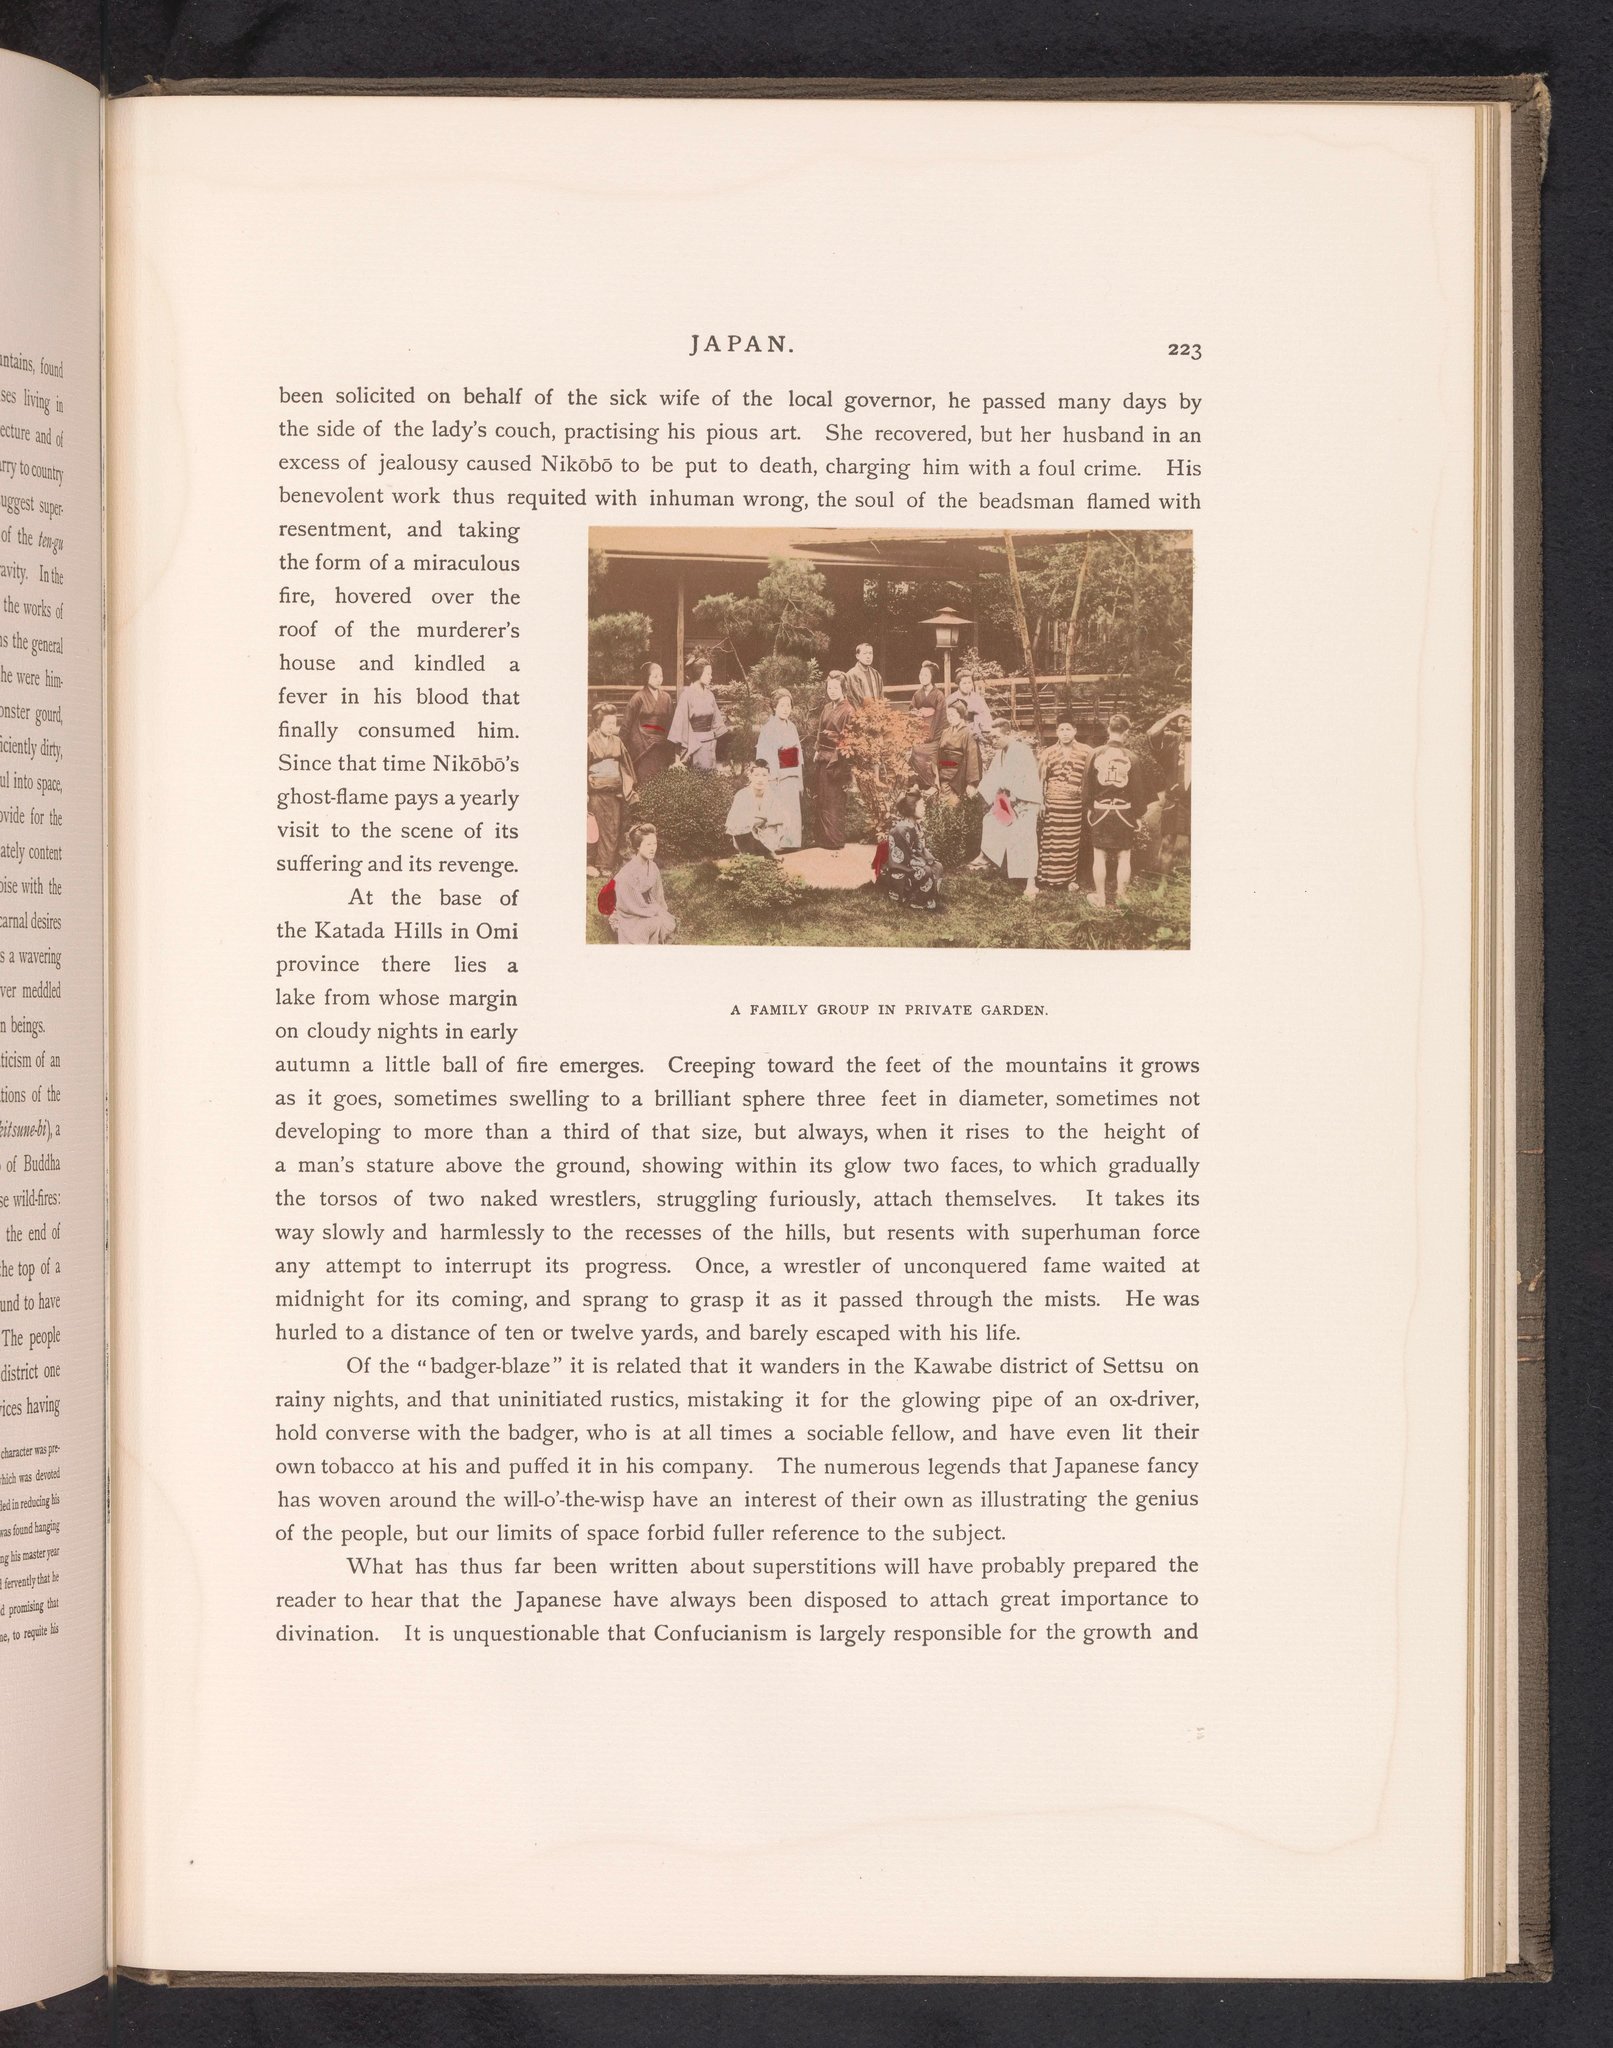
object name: photograph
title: A family group in private garden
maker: Anonymous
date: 1887-1897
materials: photographic support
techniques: albumen print, hand coloring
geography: japan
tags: garden, family, descendance, anonymous historical persons portrayed in a group, in a group-portrait